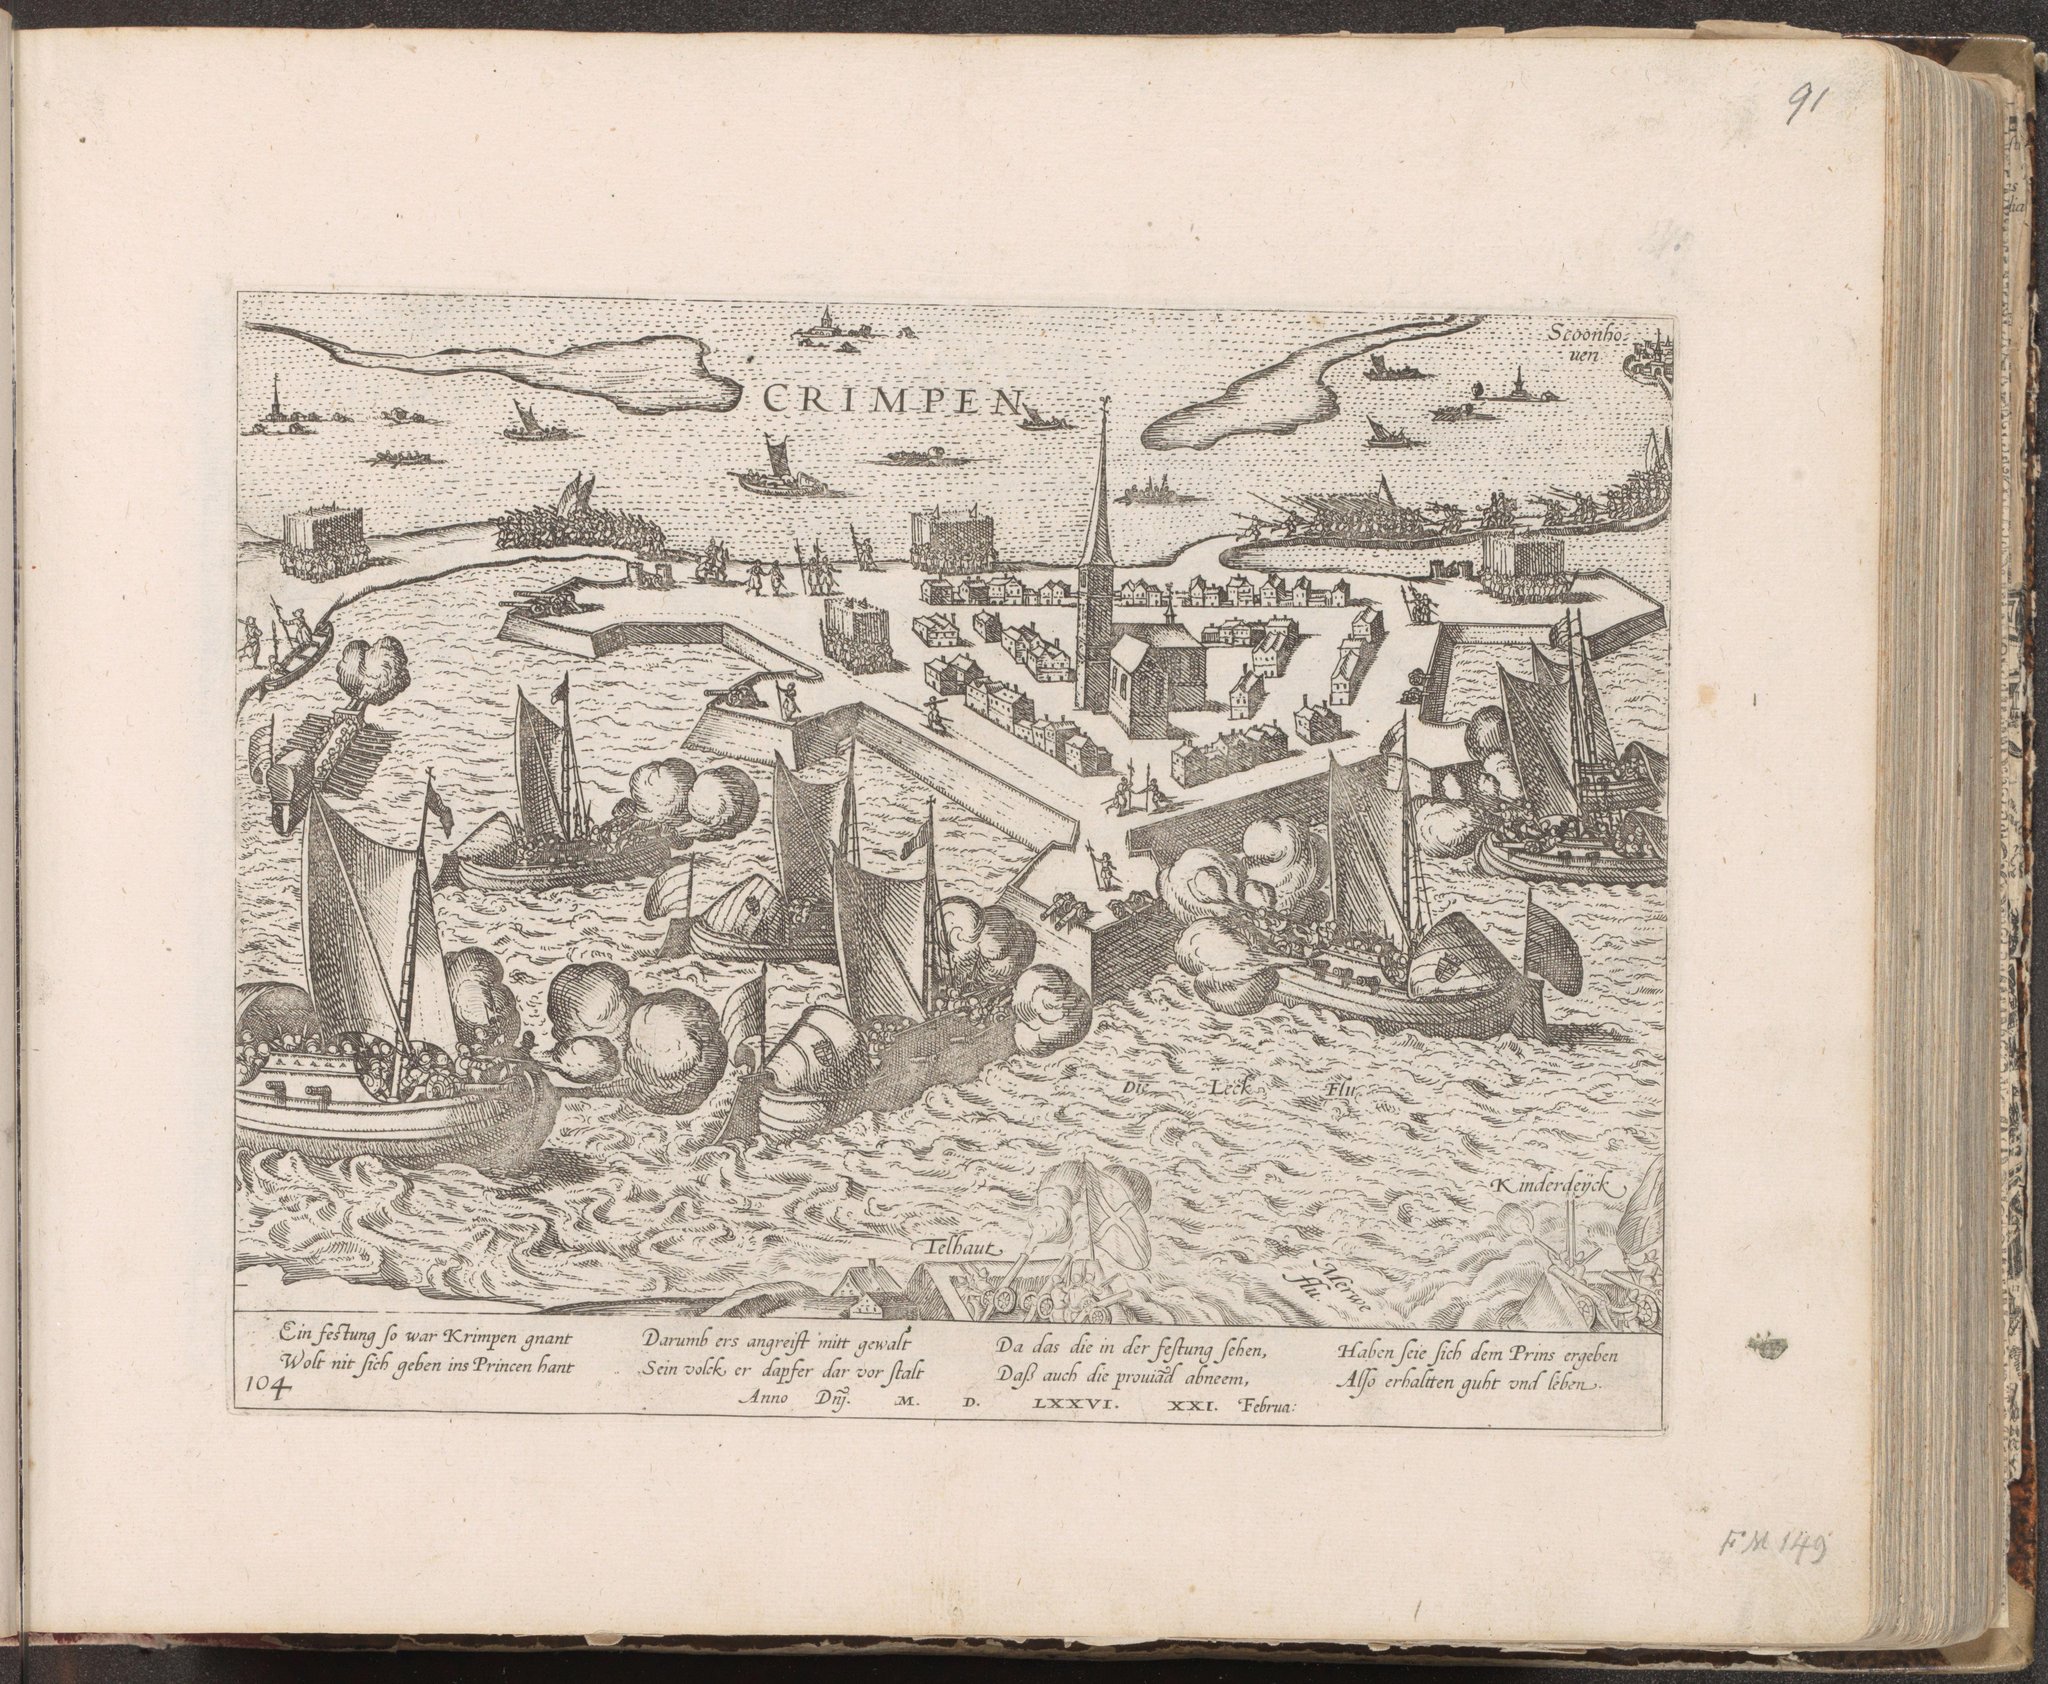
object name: album leaf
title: Serie 6: Nederlandse Gebeurtenissen, 1571-1576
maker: frans hogenberg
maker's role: print maker, publisher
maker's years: 1538-1590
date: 1576-1578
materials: paper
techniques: etching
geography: cologne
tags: siege, position war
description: Beleg van Krimpen aan de Lek door het leger van de prins. Schepen van de prins beschieten het versterkte stadje vanaf het water. Op 21 februari 1576 geeft Krimpen zich over. Met onderschrift van 8 regels in het Duits. Linksonder genummerd: 104. De prent maakt deel uit van een album.